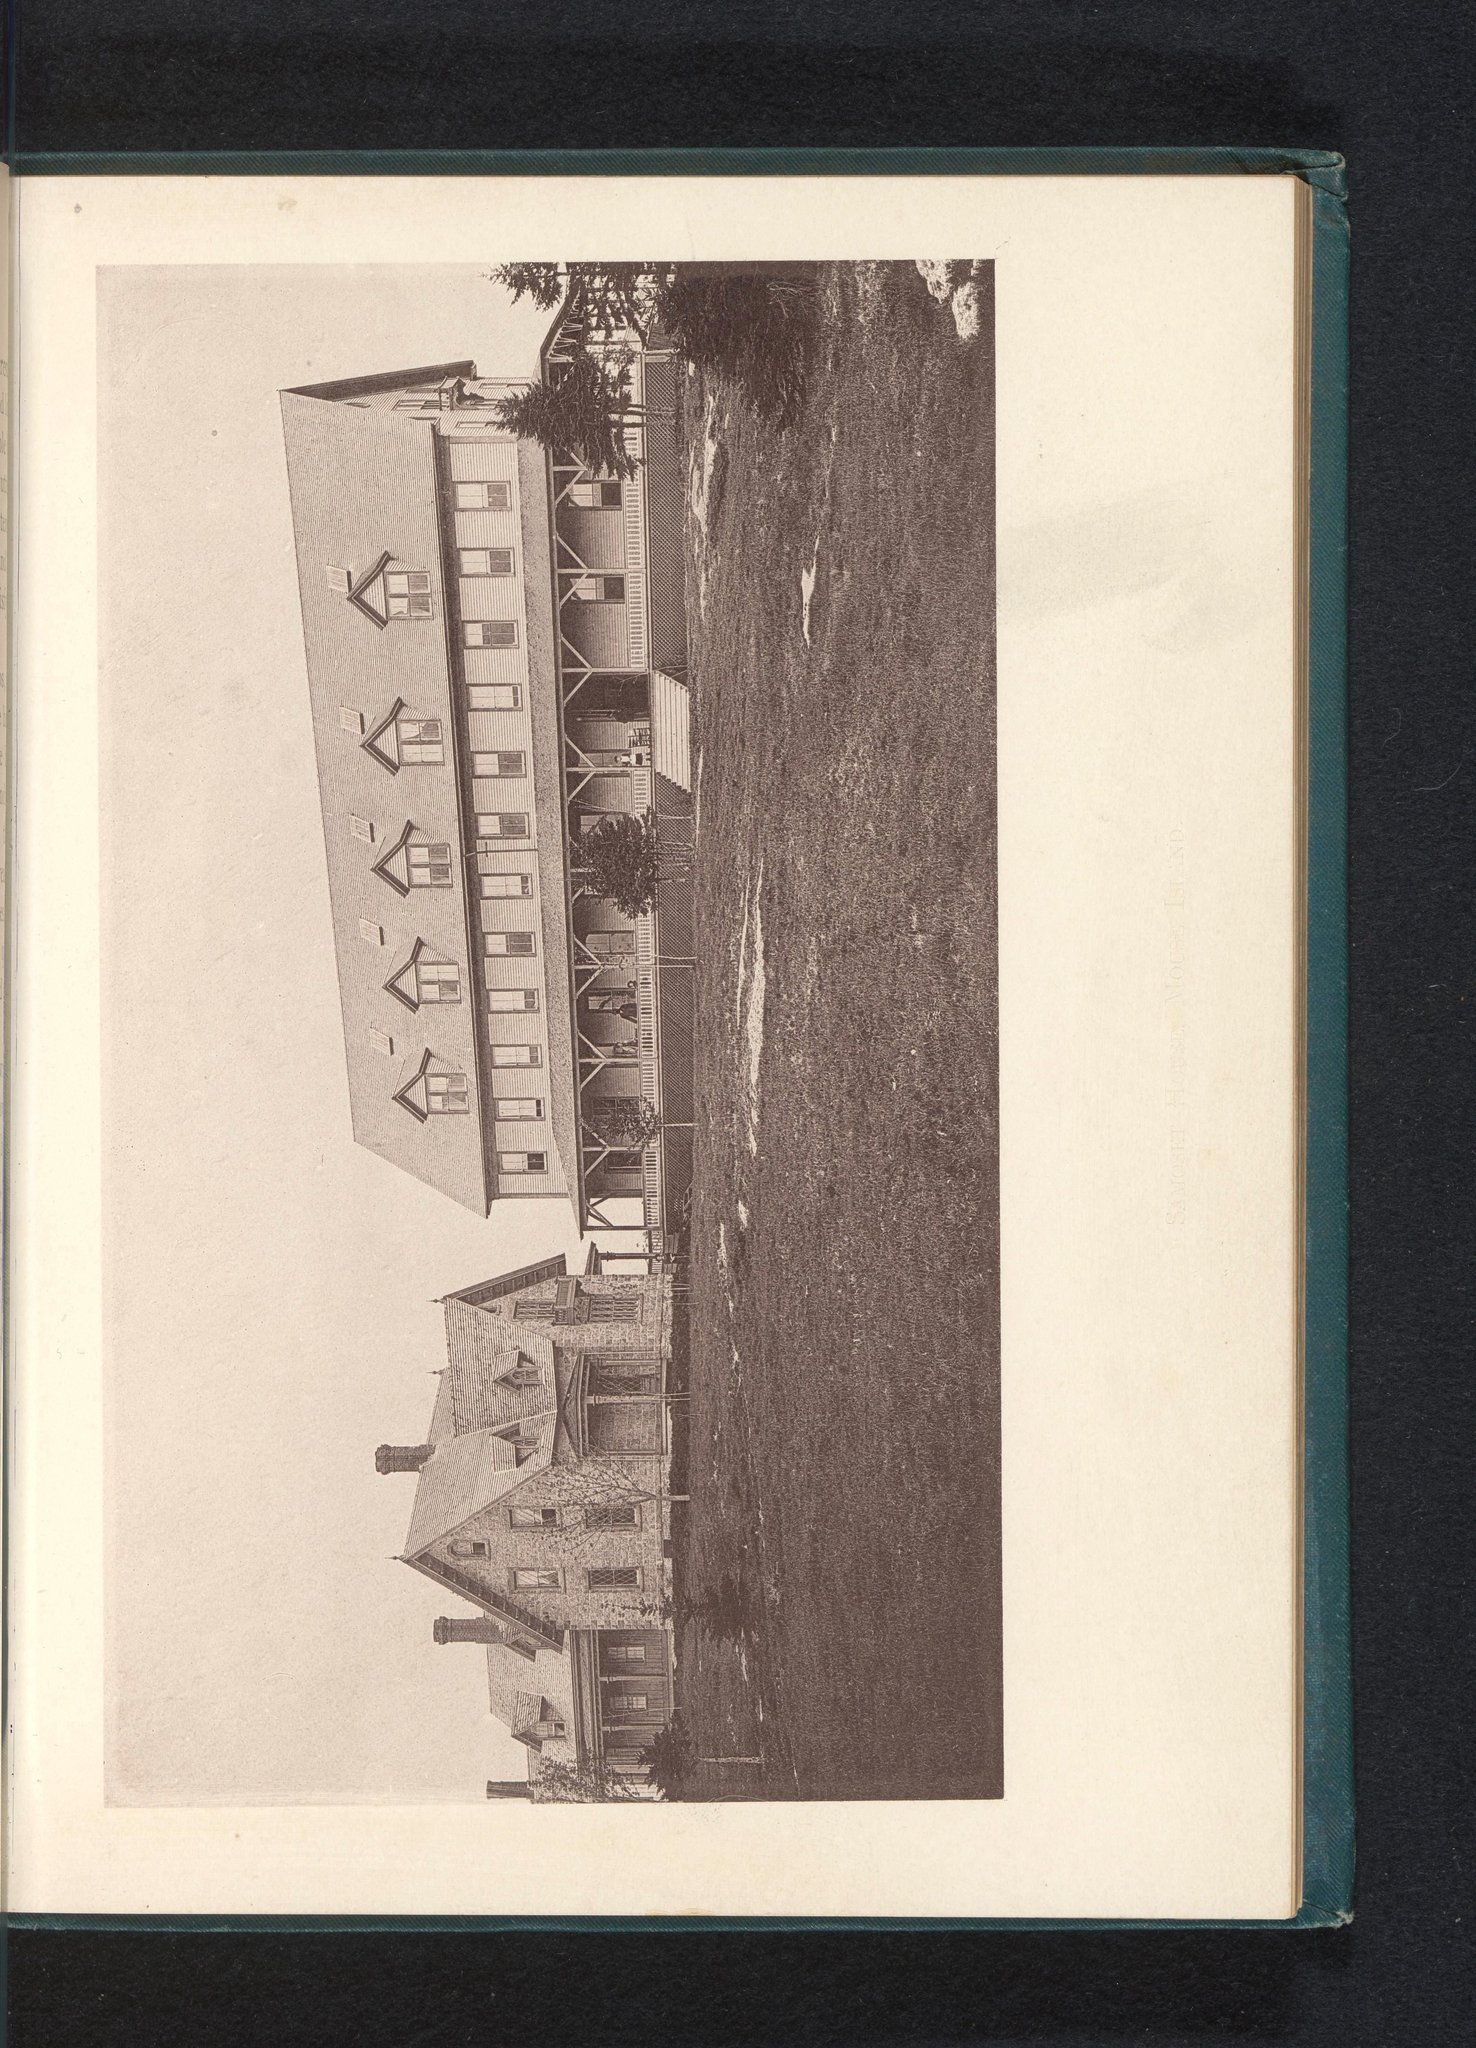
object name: photomechanical print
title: Gezicht op Samoset House op Mouse Island, Maine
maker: Anonymous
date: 1875-1880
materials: paper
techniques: photograph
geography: mouse island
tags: hotel, hostelry, inn